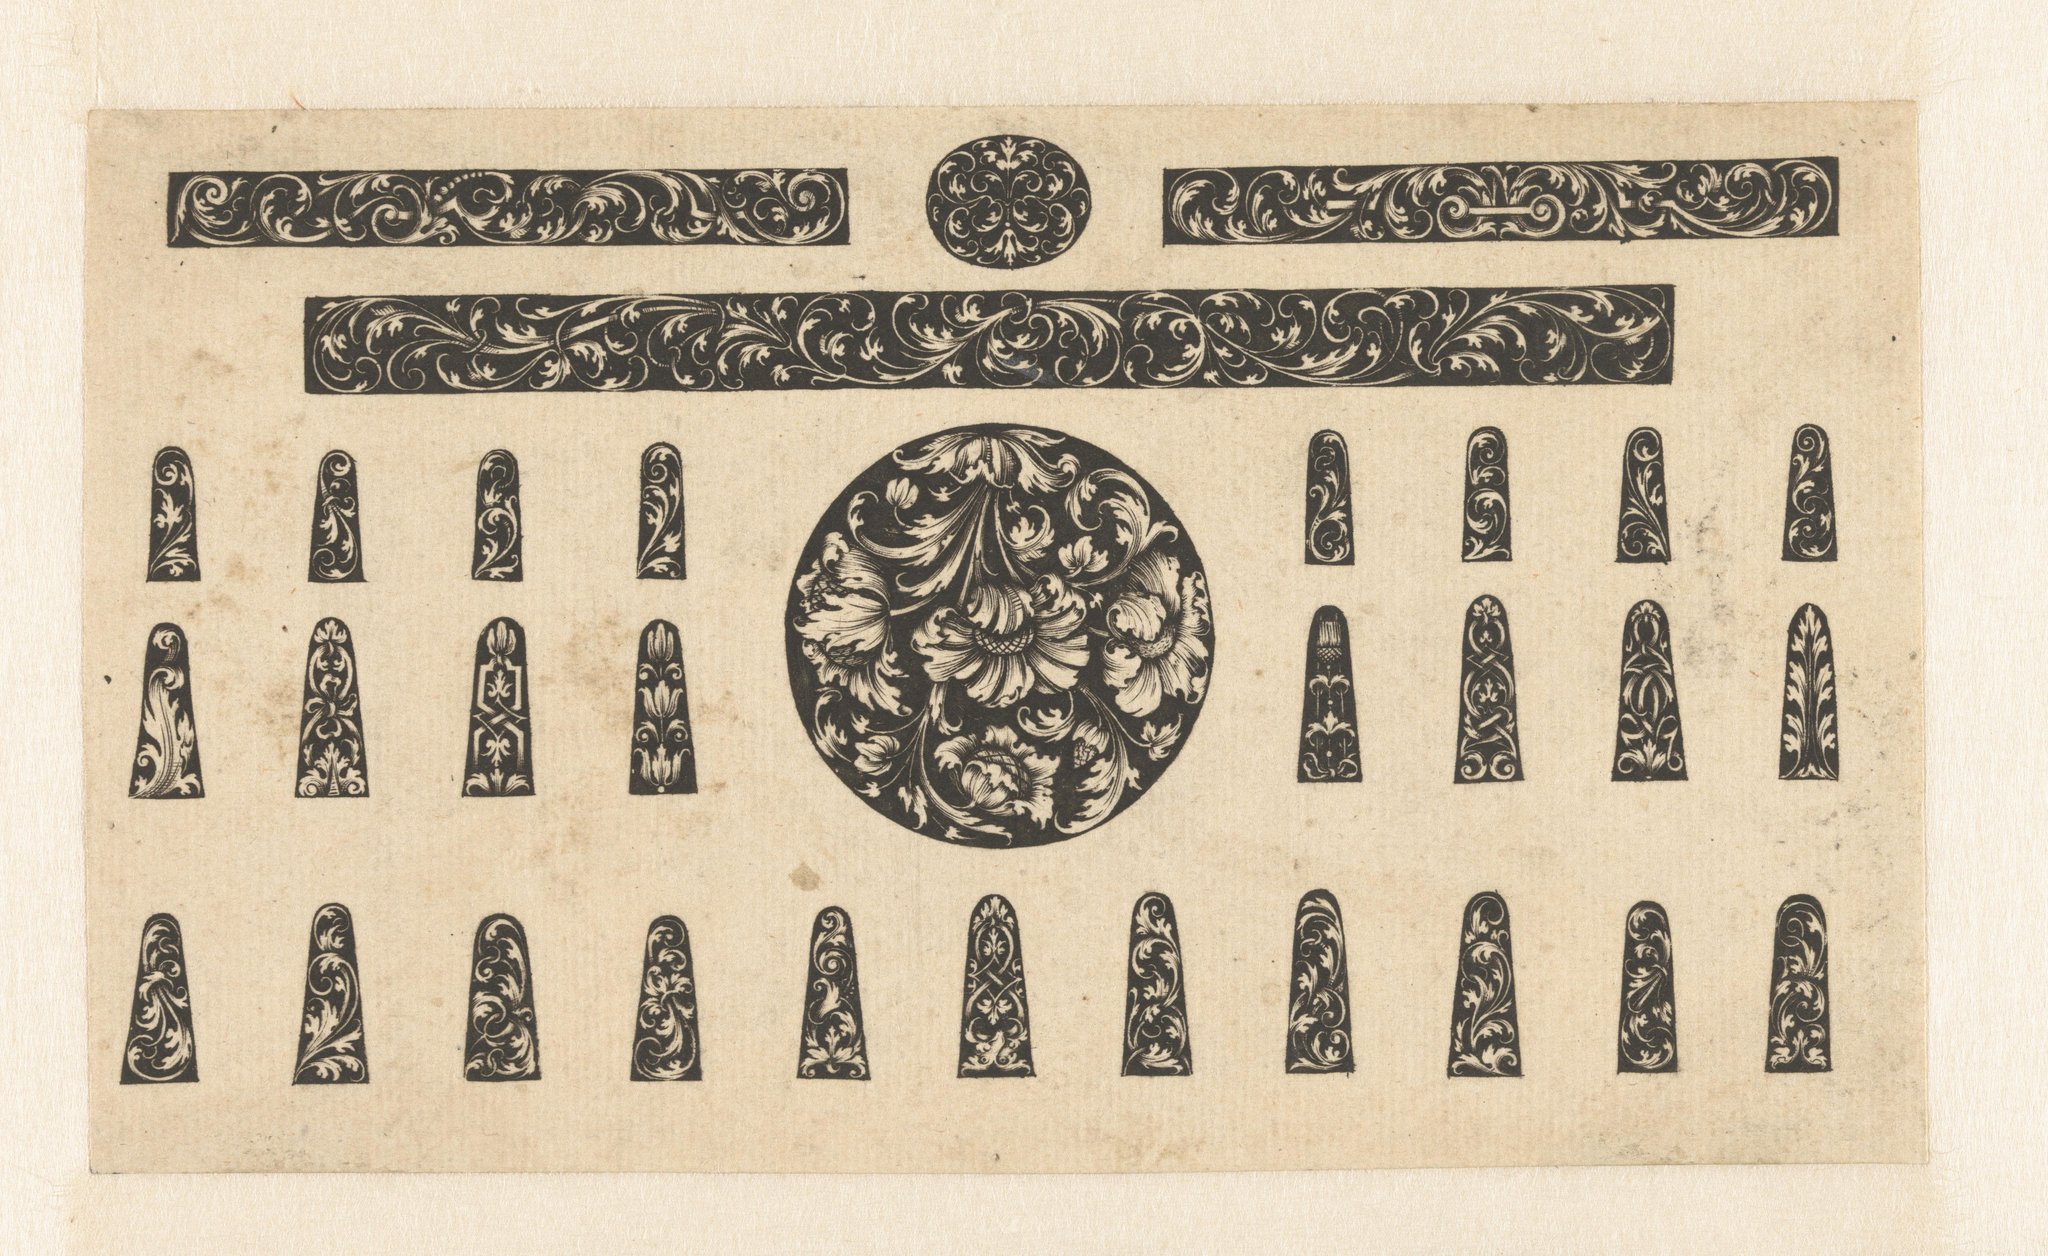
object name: print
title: Verscheidene zwartornamenten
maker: Anonymous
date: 1580-1700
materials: paper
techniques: etching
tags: ornaments ~ art, foliage ~ ornament, ornament ~ medallion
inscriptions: collector's mark: Lugt 2228, collector's mark: 2760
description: Verscheidene zwartornamenten bestaande uit gestilleerde ranken met in het midden een medaillon, bovenaan drie stroken en rondom 27 motieven.